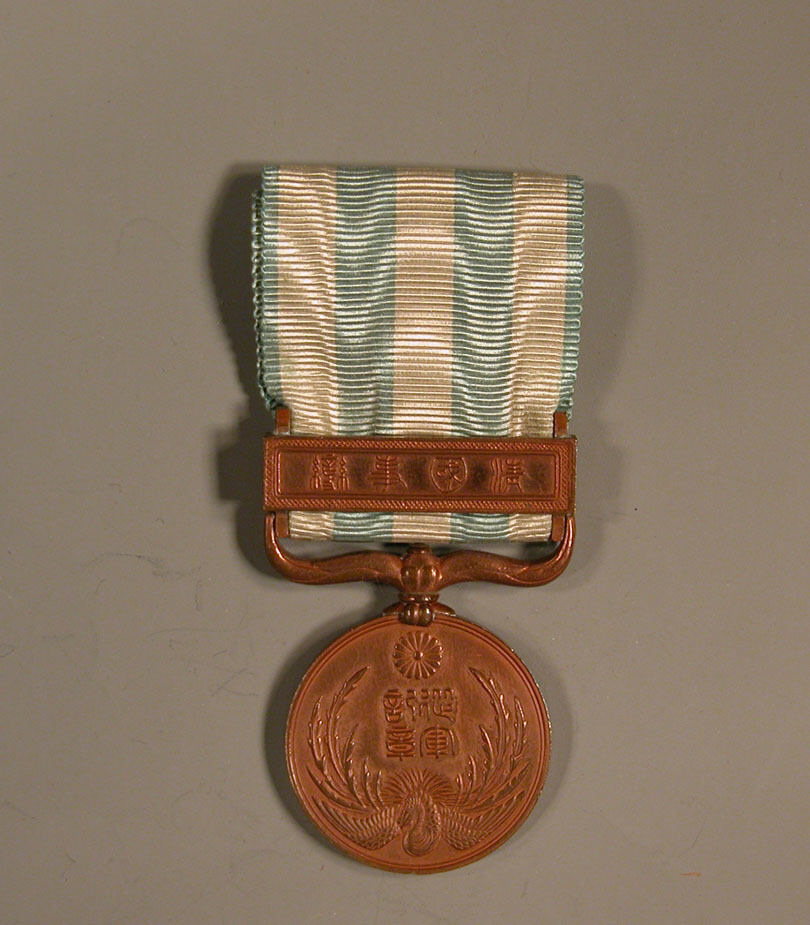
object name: medal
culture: japanese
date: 1867-1900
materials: bronze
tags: emblems